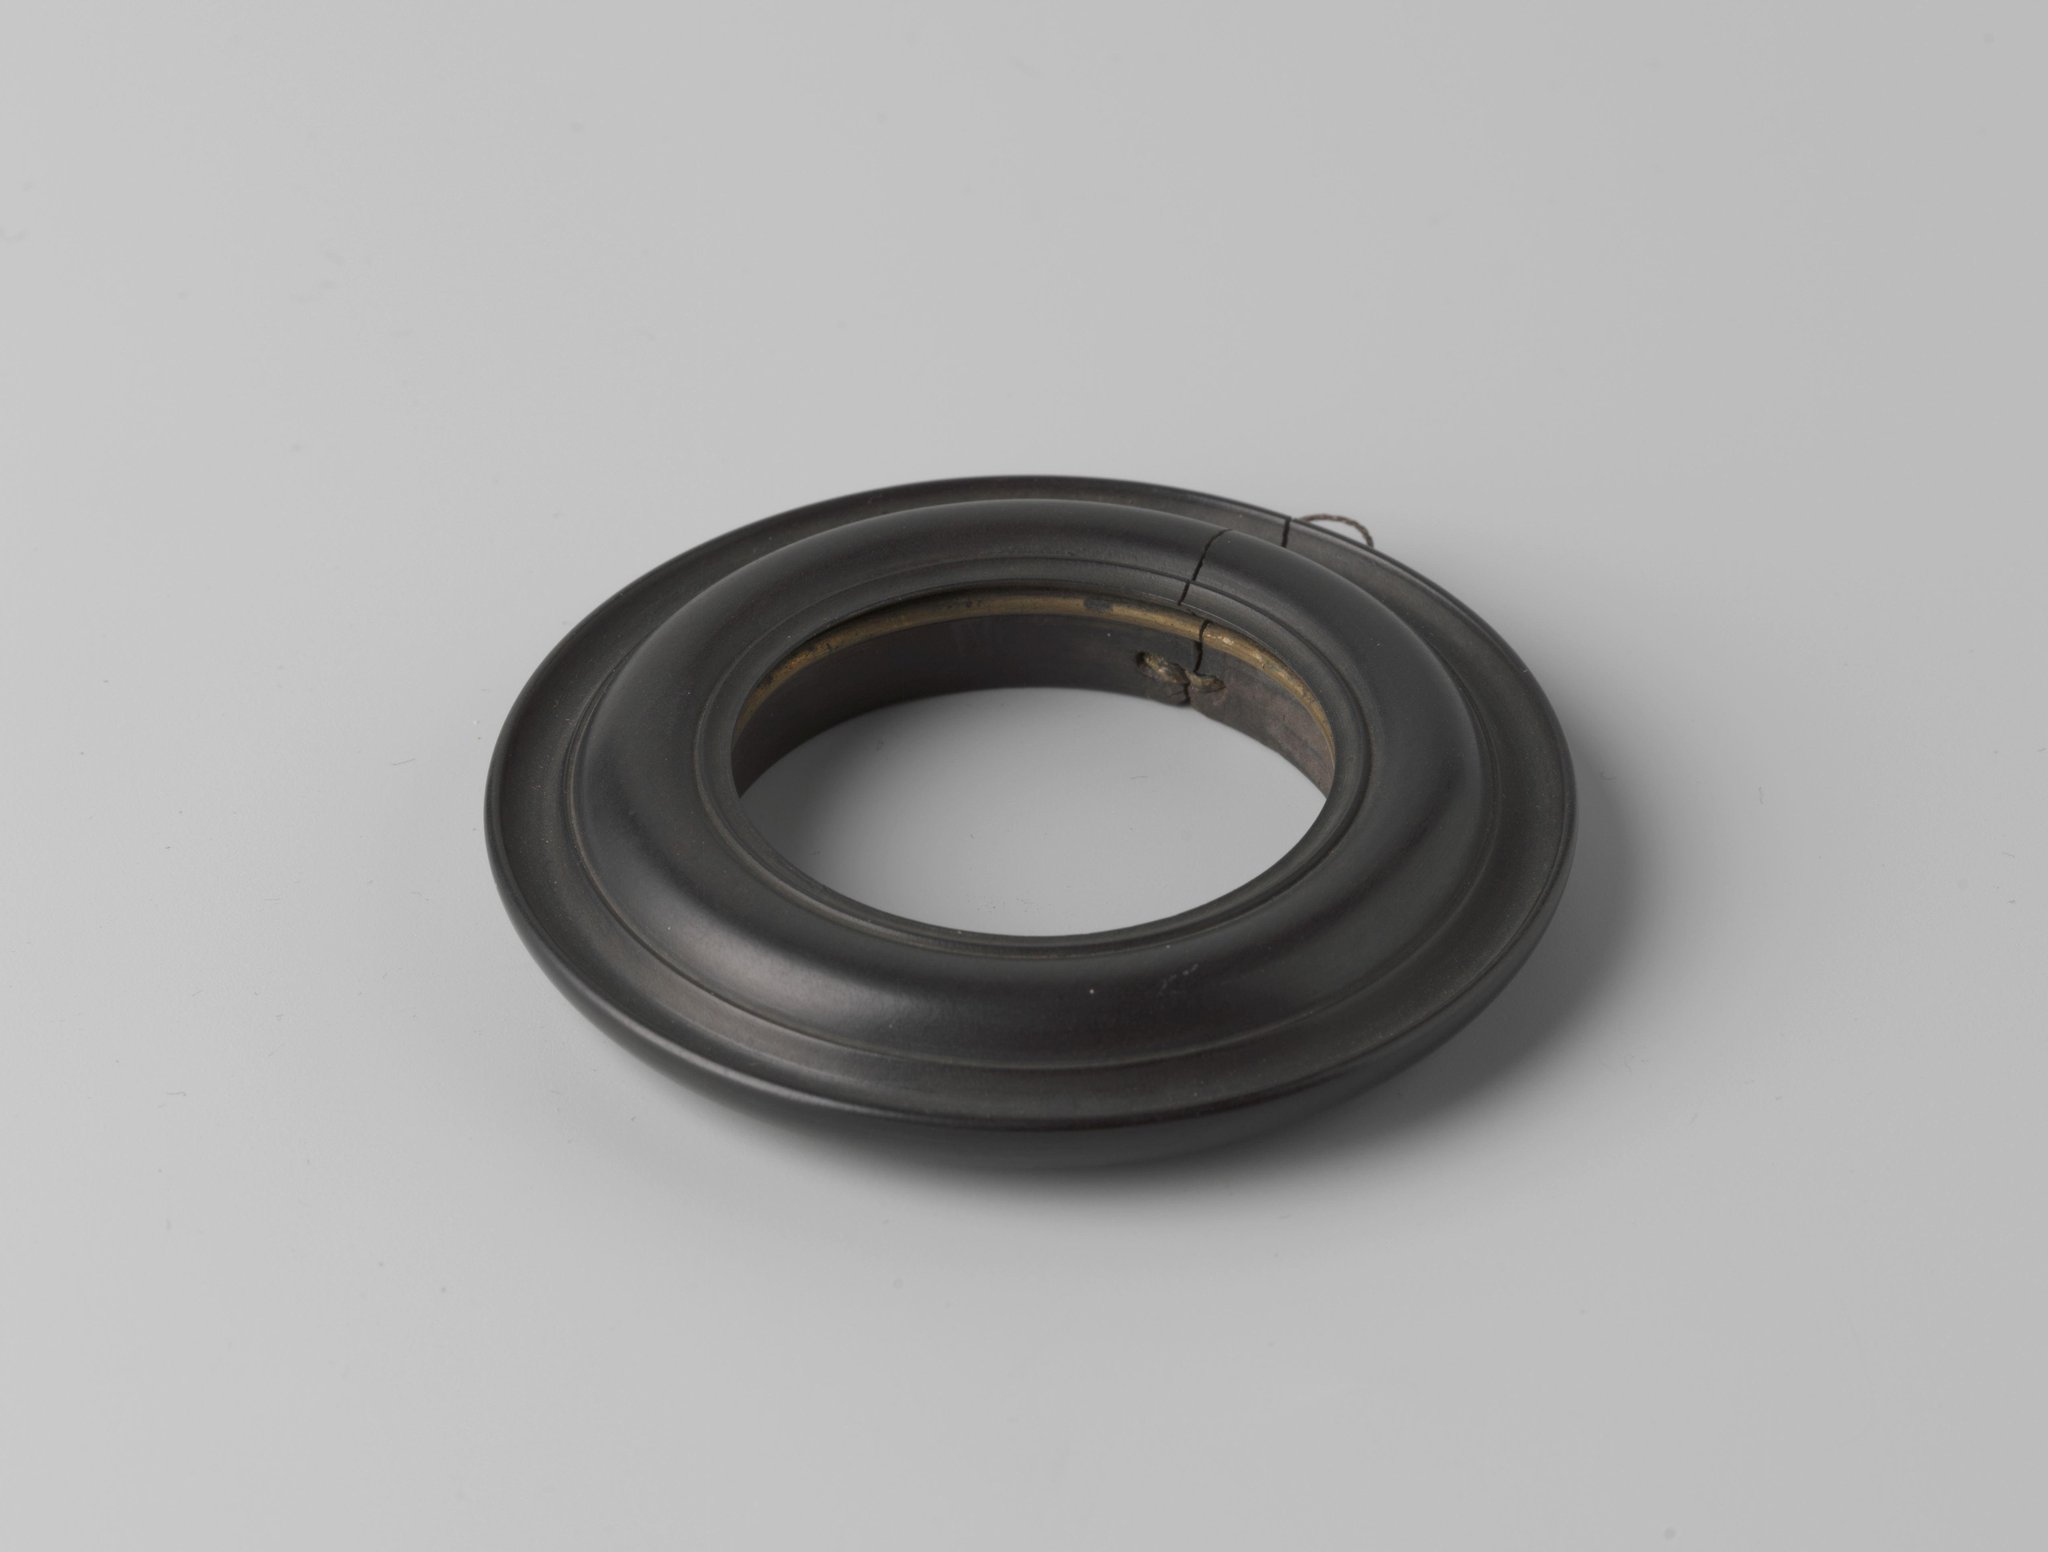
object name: frame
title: Houten lijst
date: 1400-1950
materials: wood